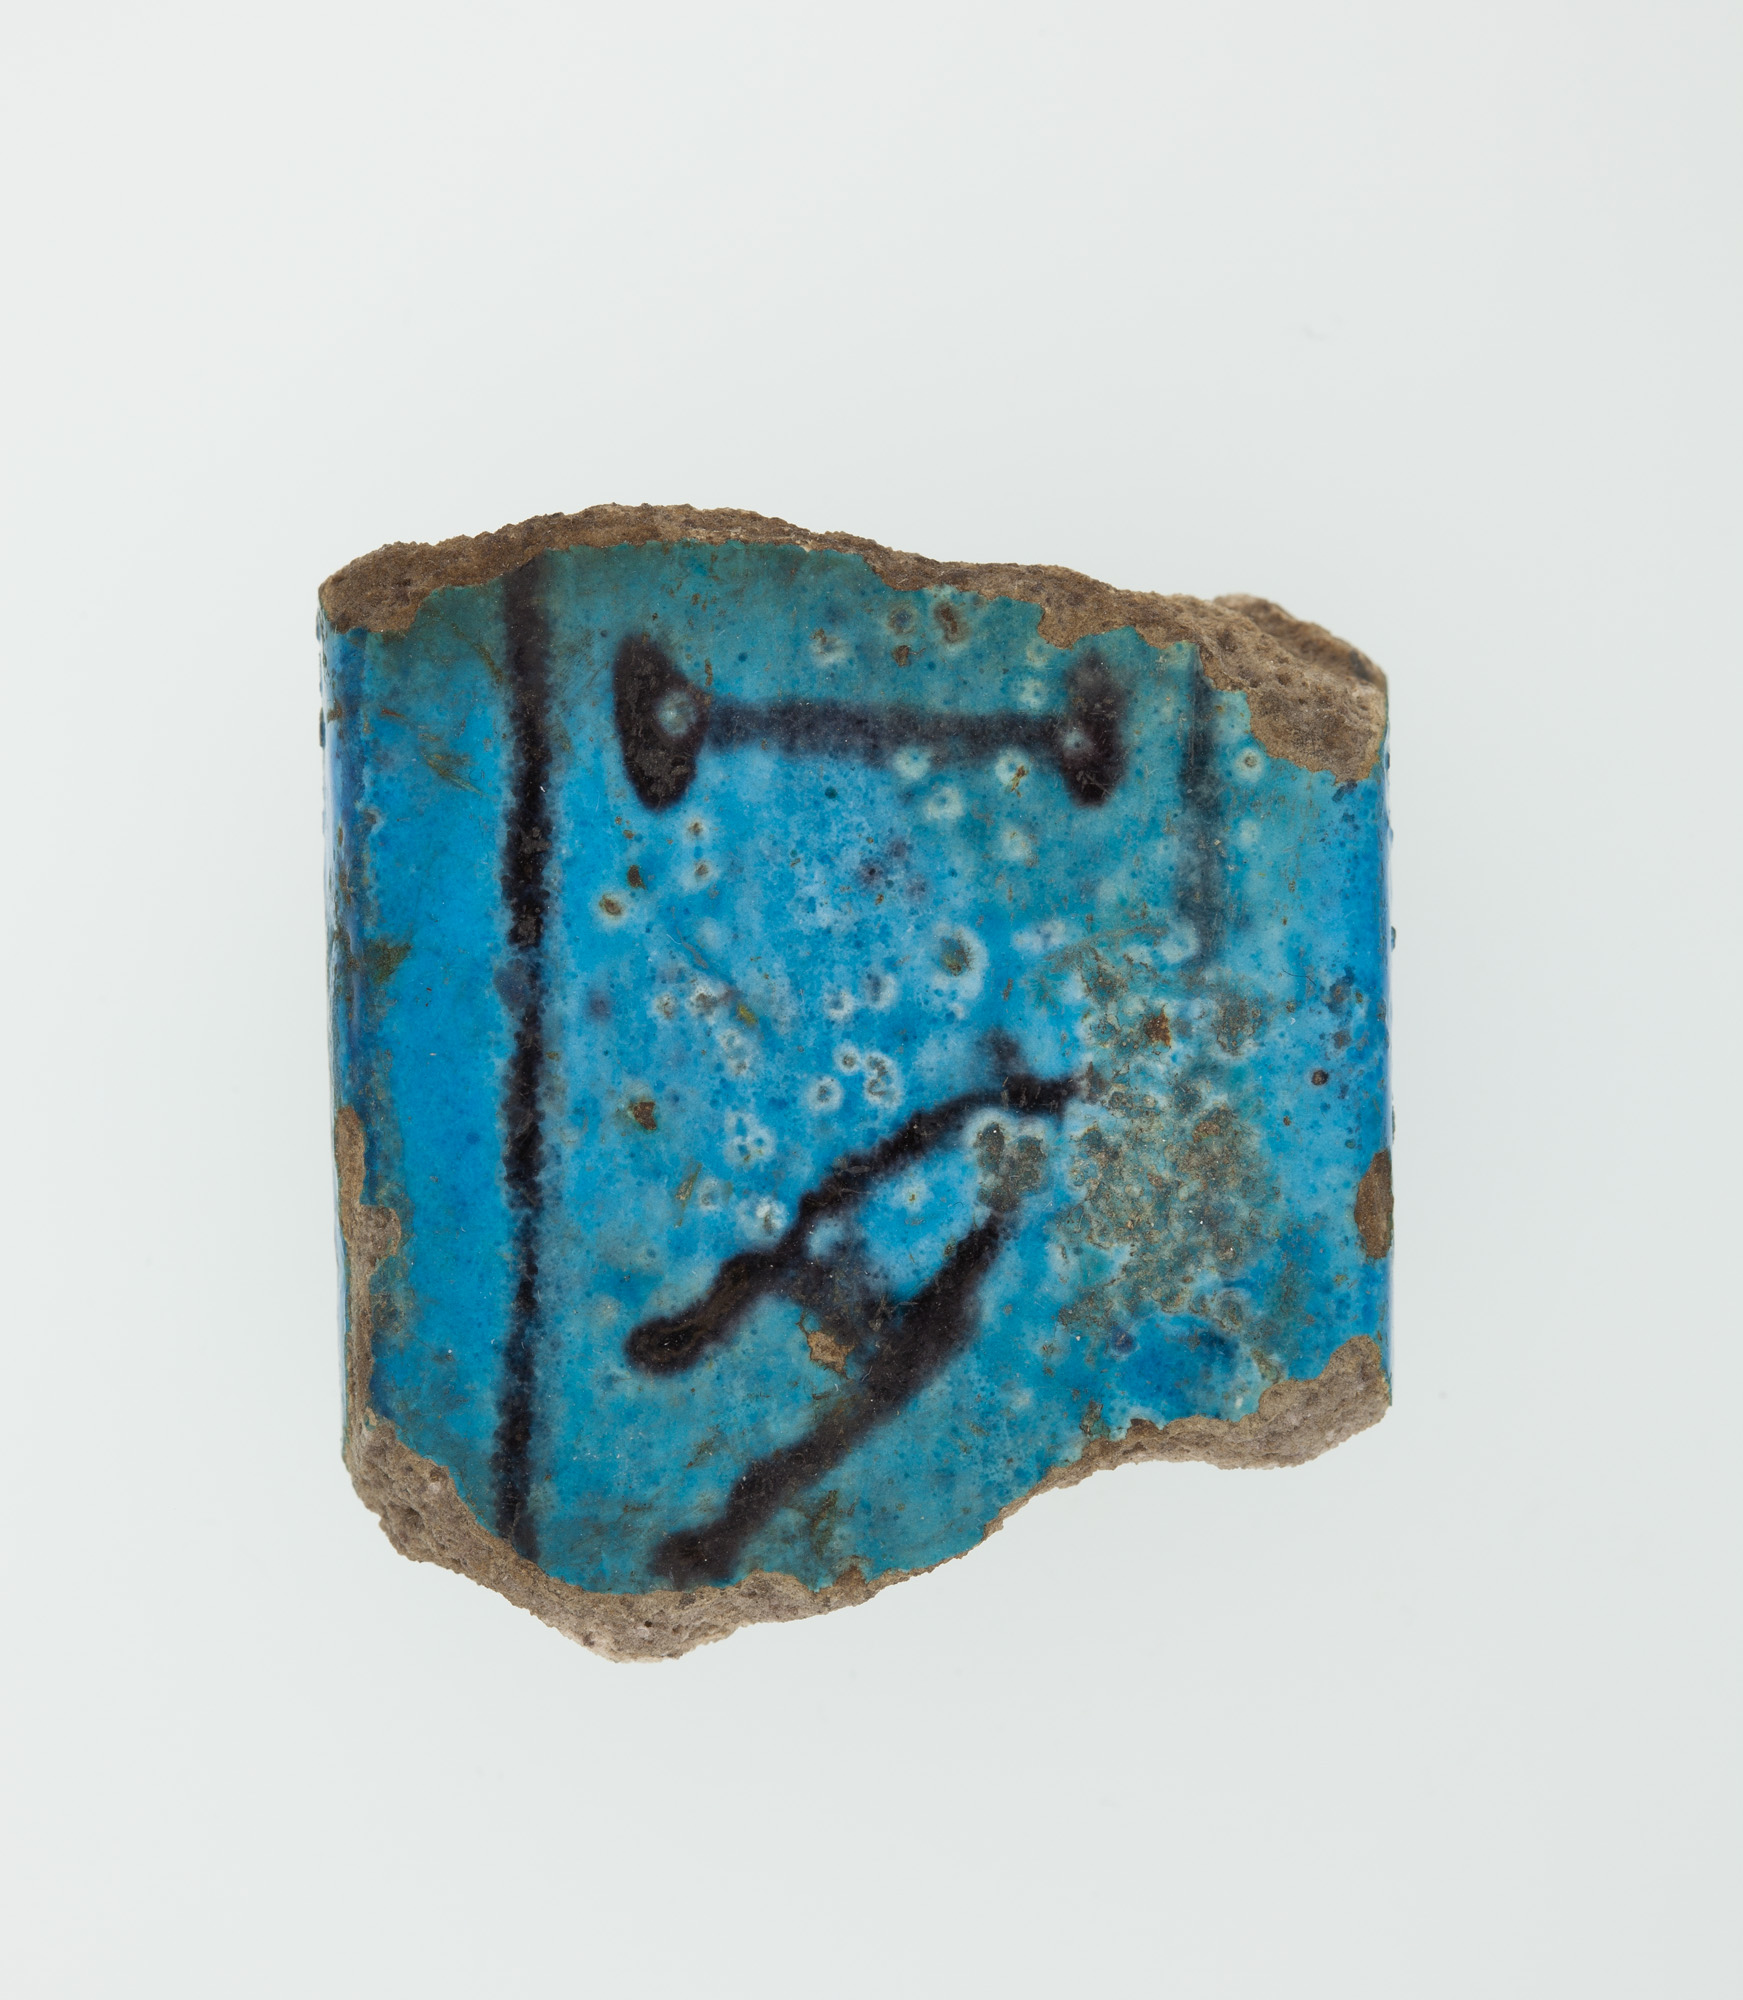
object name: menat fragment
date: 1479-1458 BCE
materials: faience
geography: egypt